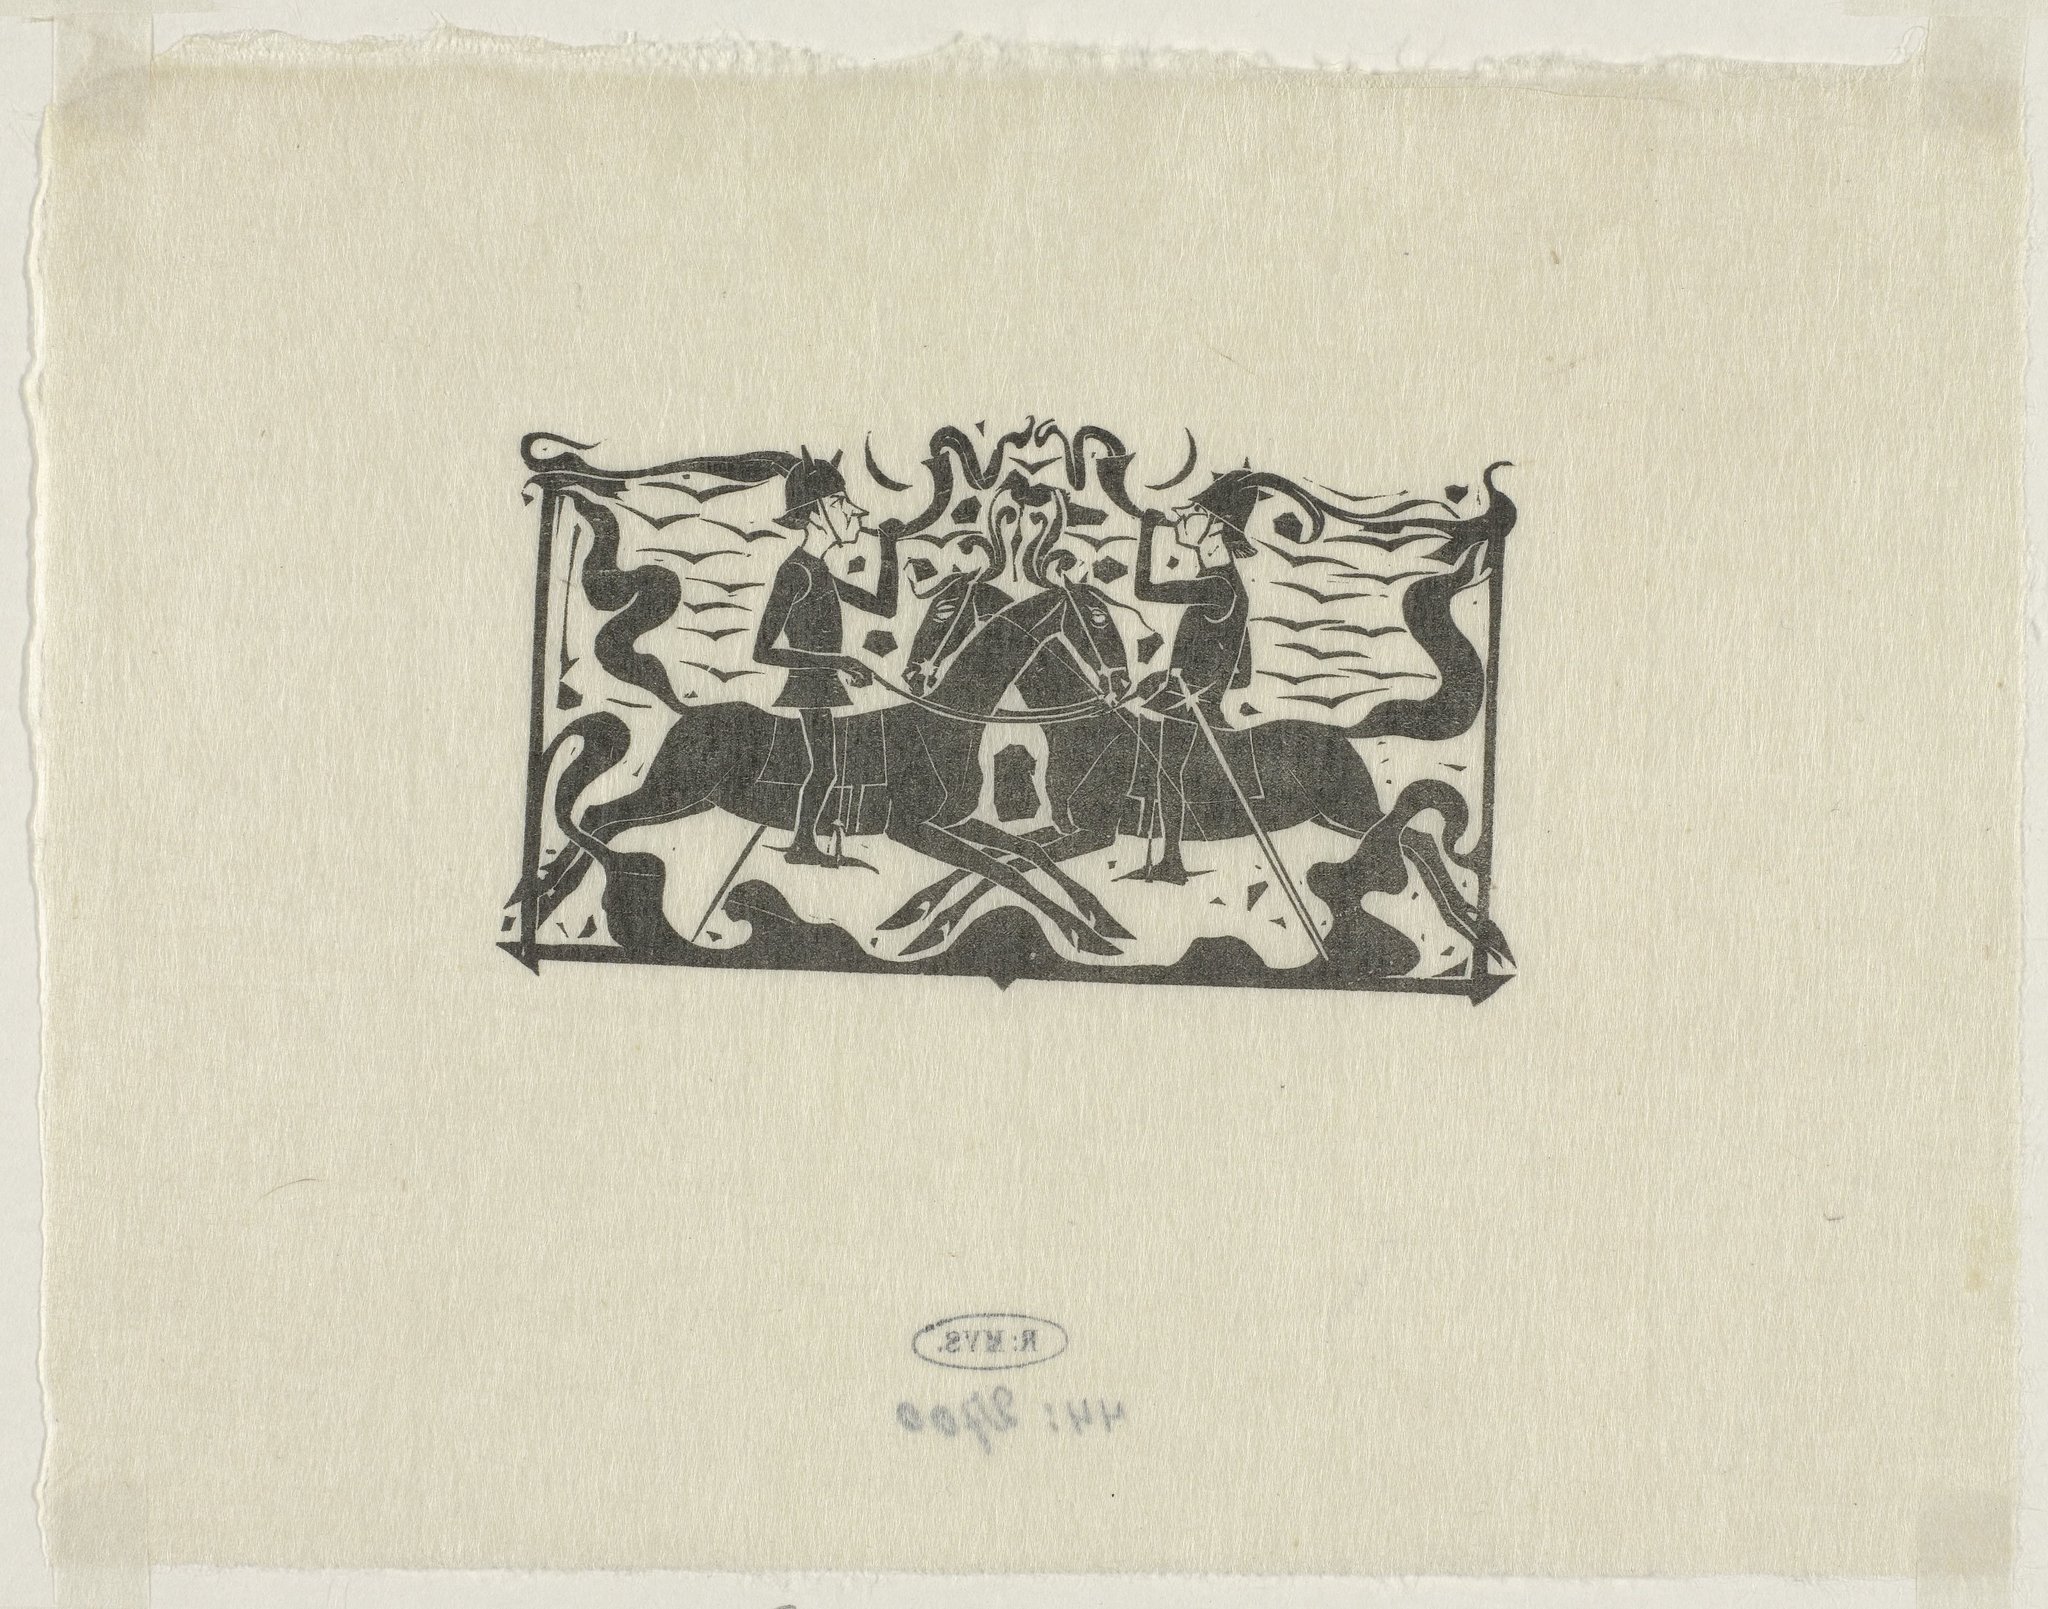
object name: print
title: Titelhoofd met ruiters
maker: gerrit willem dijsselhof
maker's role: designer, draughtsman, print maker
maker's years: 1866-1924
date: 1893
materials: paper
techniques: woodcut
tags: riding a horse, ass, or mule; rider, horseman, horn, trumpet, cornet, trombone, tuba - cc - out of doors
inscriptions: collector's mark: Lugt 2228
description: Voor het boek ‘Kunst en samenleving’ (een bewerking door Jan Veth van Walter Crane’s boek ‘The Claims of Decorative Art’, 1892) ontwierp Gerrit Willem Dijsselhof een aantal kopvignetten. Zowel qua onderwerp, voorstelling als uitvoering vertonen ze overeenkomsten met enkele hier getoonde prenten van Escher. Hoewel deze ruiters elkaar overlappen, doet dit werk sterk aan diens ‘Horseman’ denken.